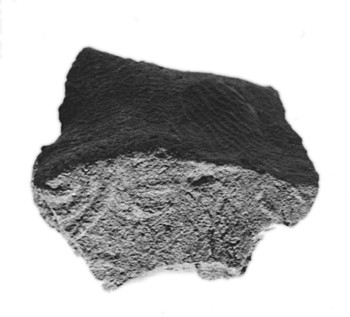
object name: sealing fragment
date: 2030-1640 BCE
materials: clay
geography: egypt